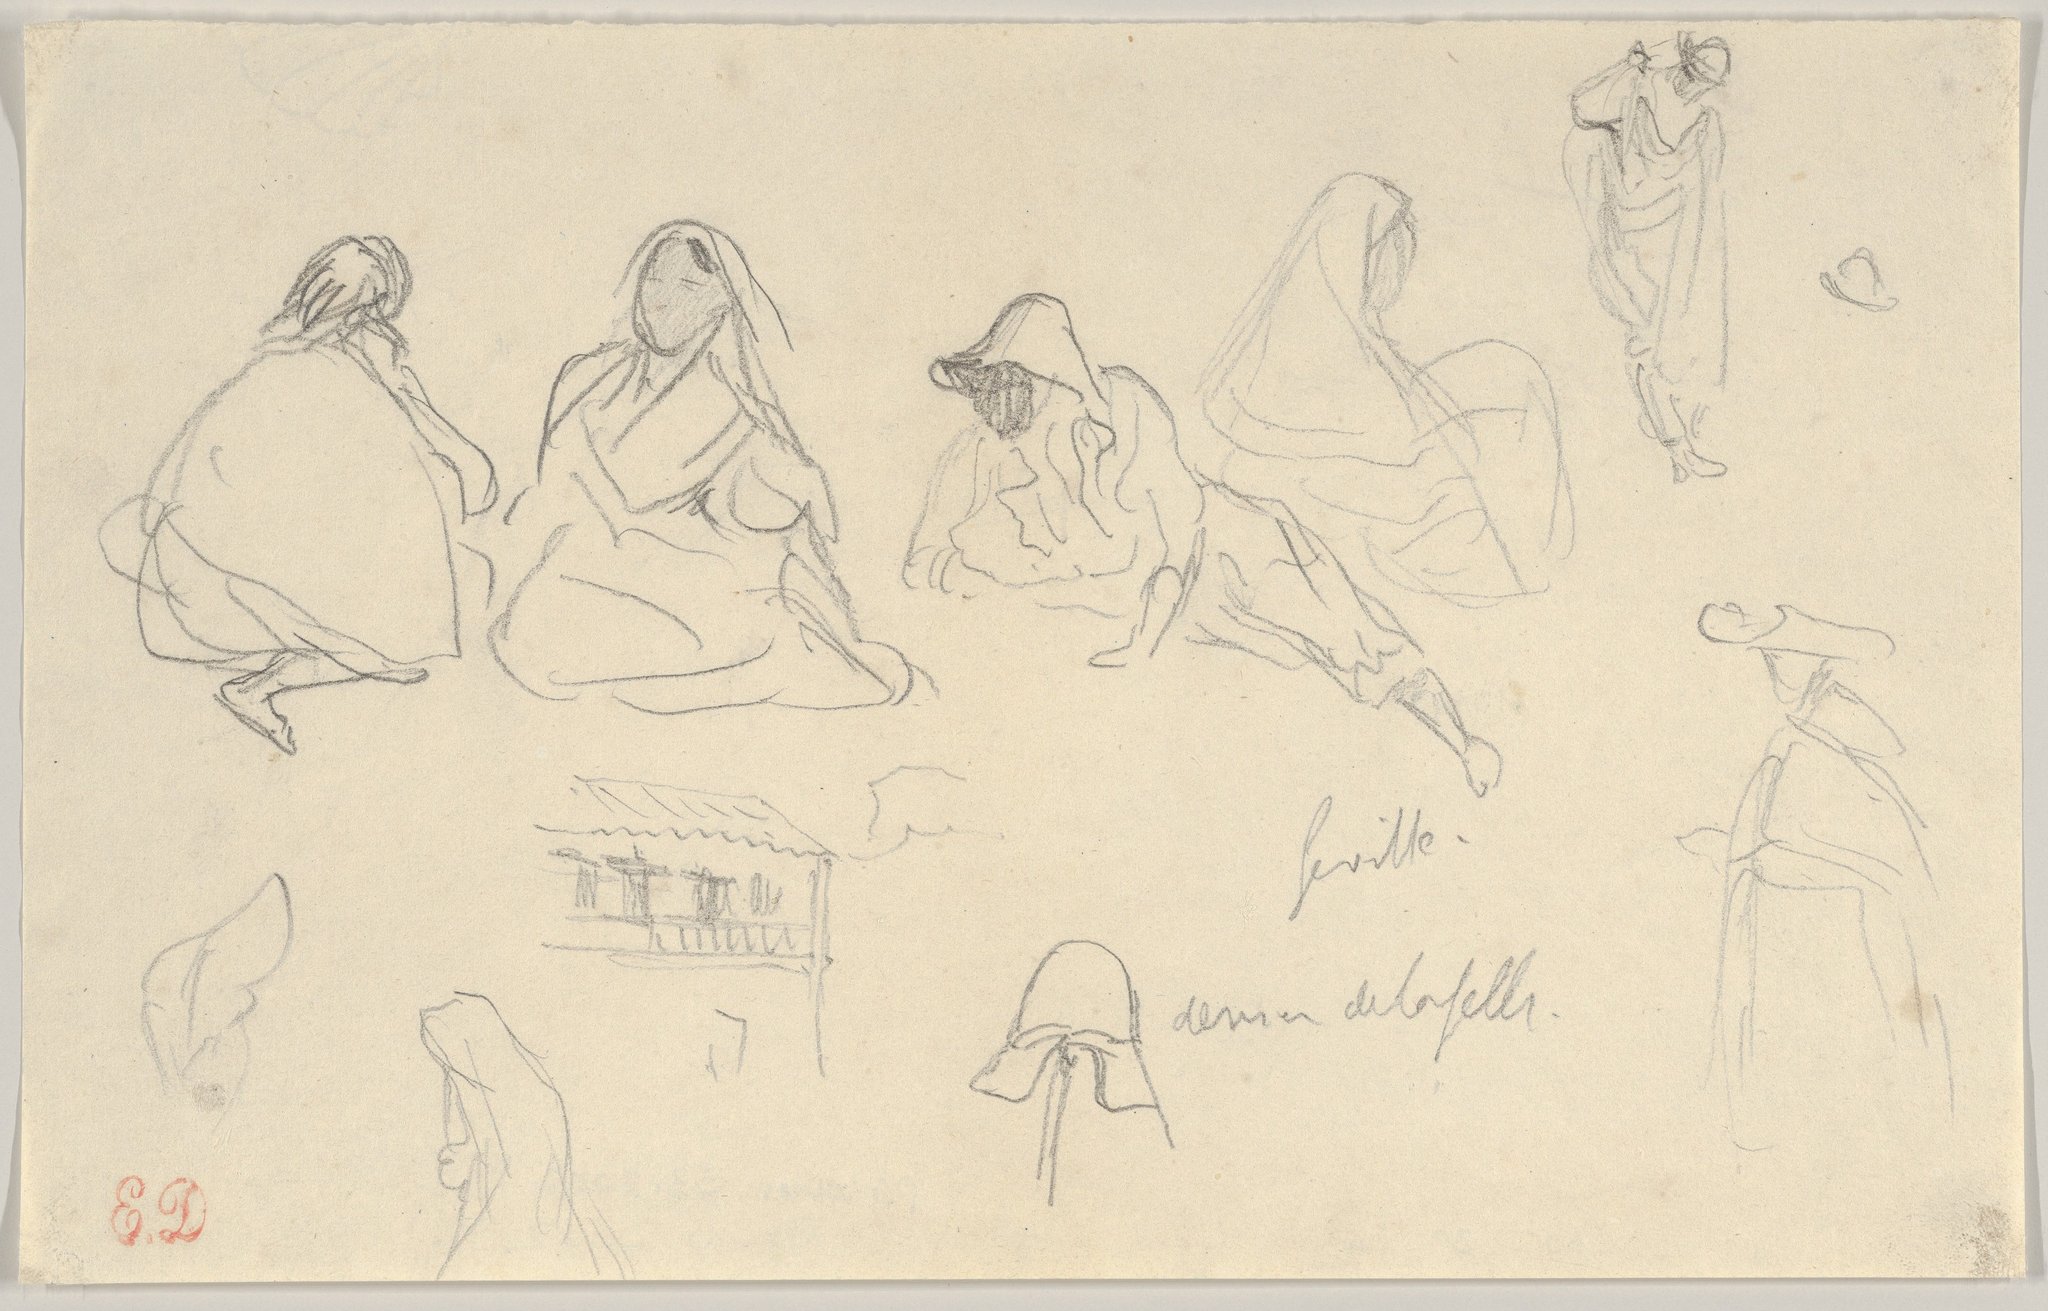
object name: drawing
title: Sketches of Figures and a Tile-Roofed Building, Seville, Spain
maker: eugène delacroix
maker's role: artist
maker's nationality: french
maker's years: 1798-1863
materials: graphite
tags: buildings,women